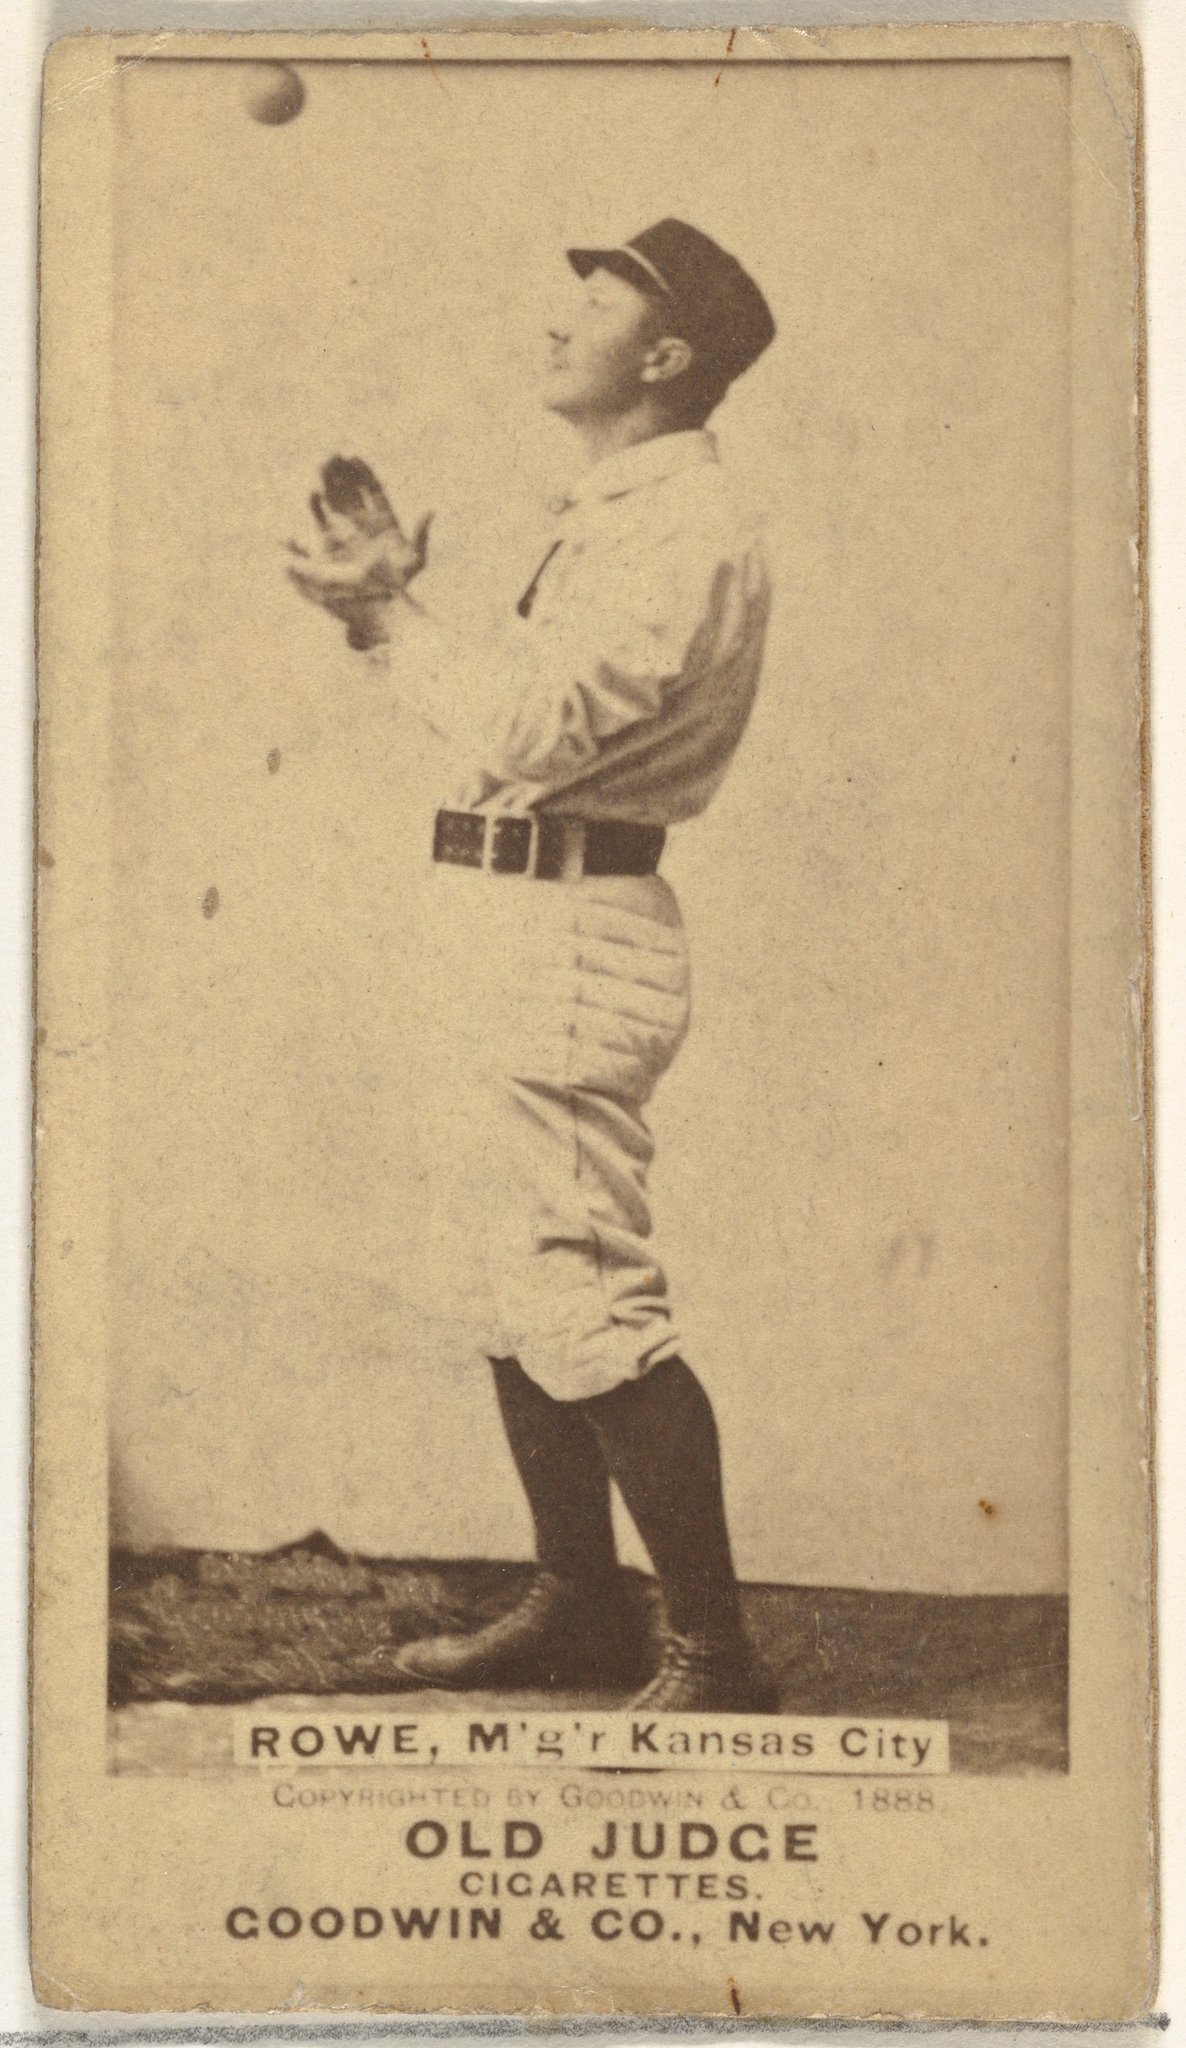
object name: baseball card, photograph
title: David Elwood "Dave" Rowe, Manager, Kansas City Cowboys, from the Old Judge series (N172) for Old Judge Cigarettes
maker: goodwin & company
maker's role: publisher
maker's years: 1850-1950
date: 1888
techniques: albumen silver print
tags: men,portraits,baseball,athletes